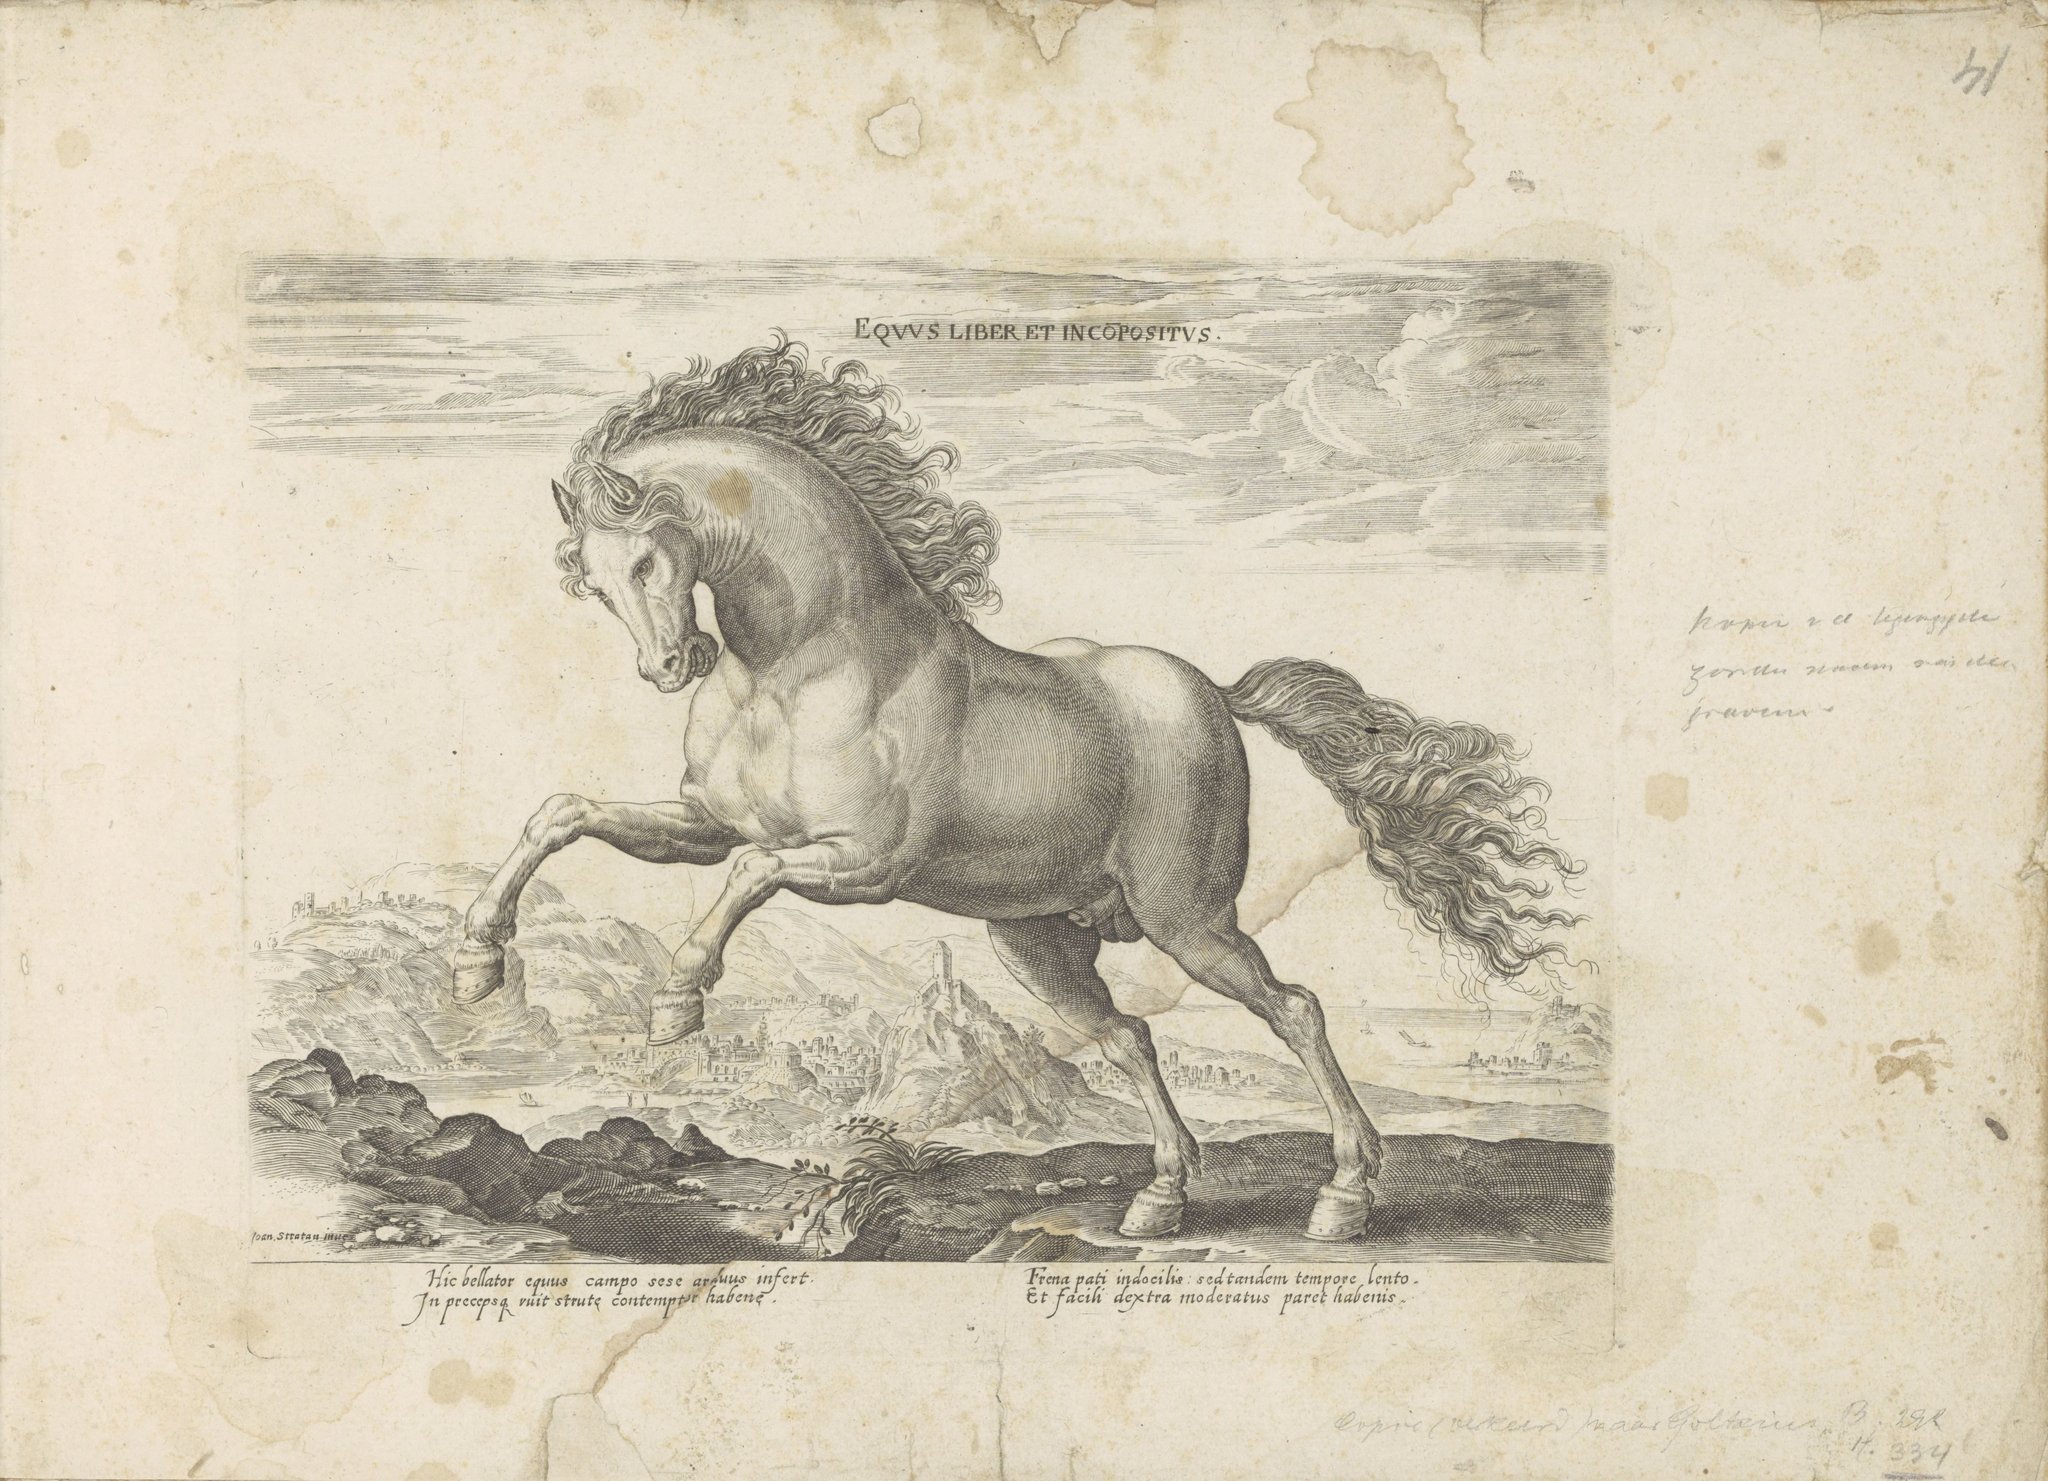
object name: album leaf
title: Wild paard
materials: paper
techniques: engraving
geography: venice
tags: don juan van oostenrijk, horse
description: Een wild paard, steigerend naar links. Op de achtergrond een stad aan een kust. Prent maakt deel uit van een album.